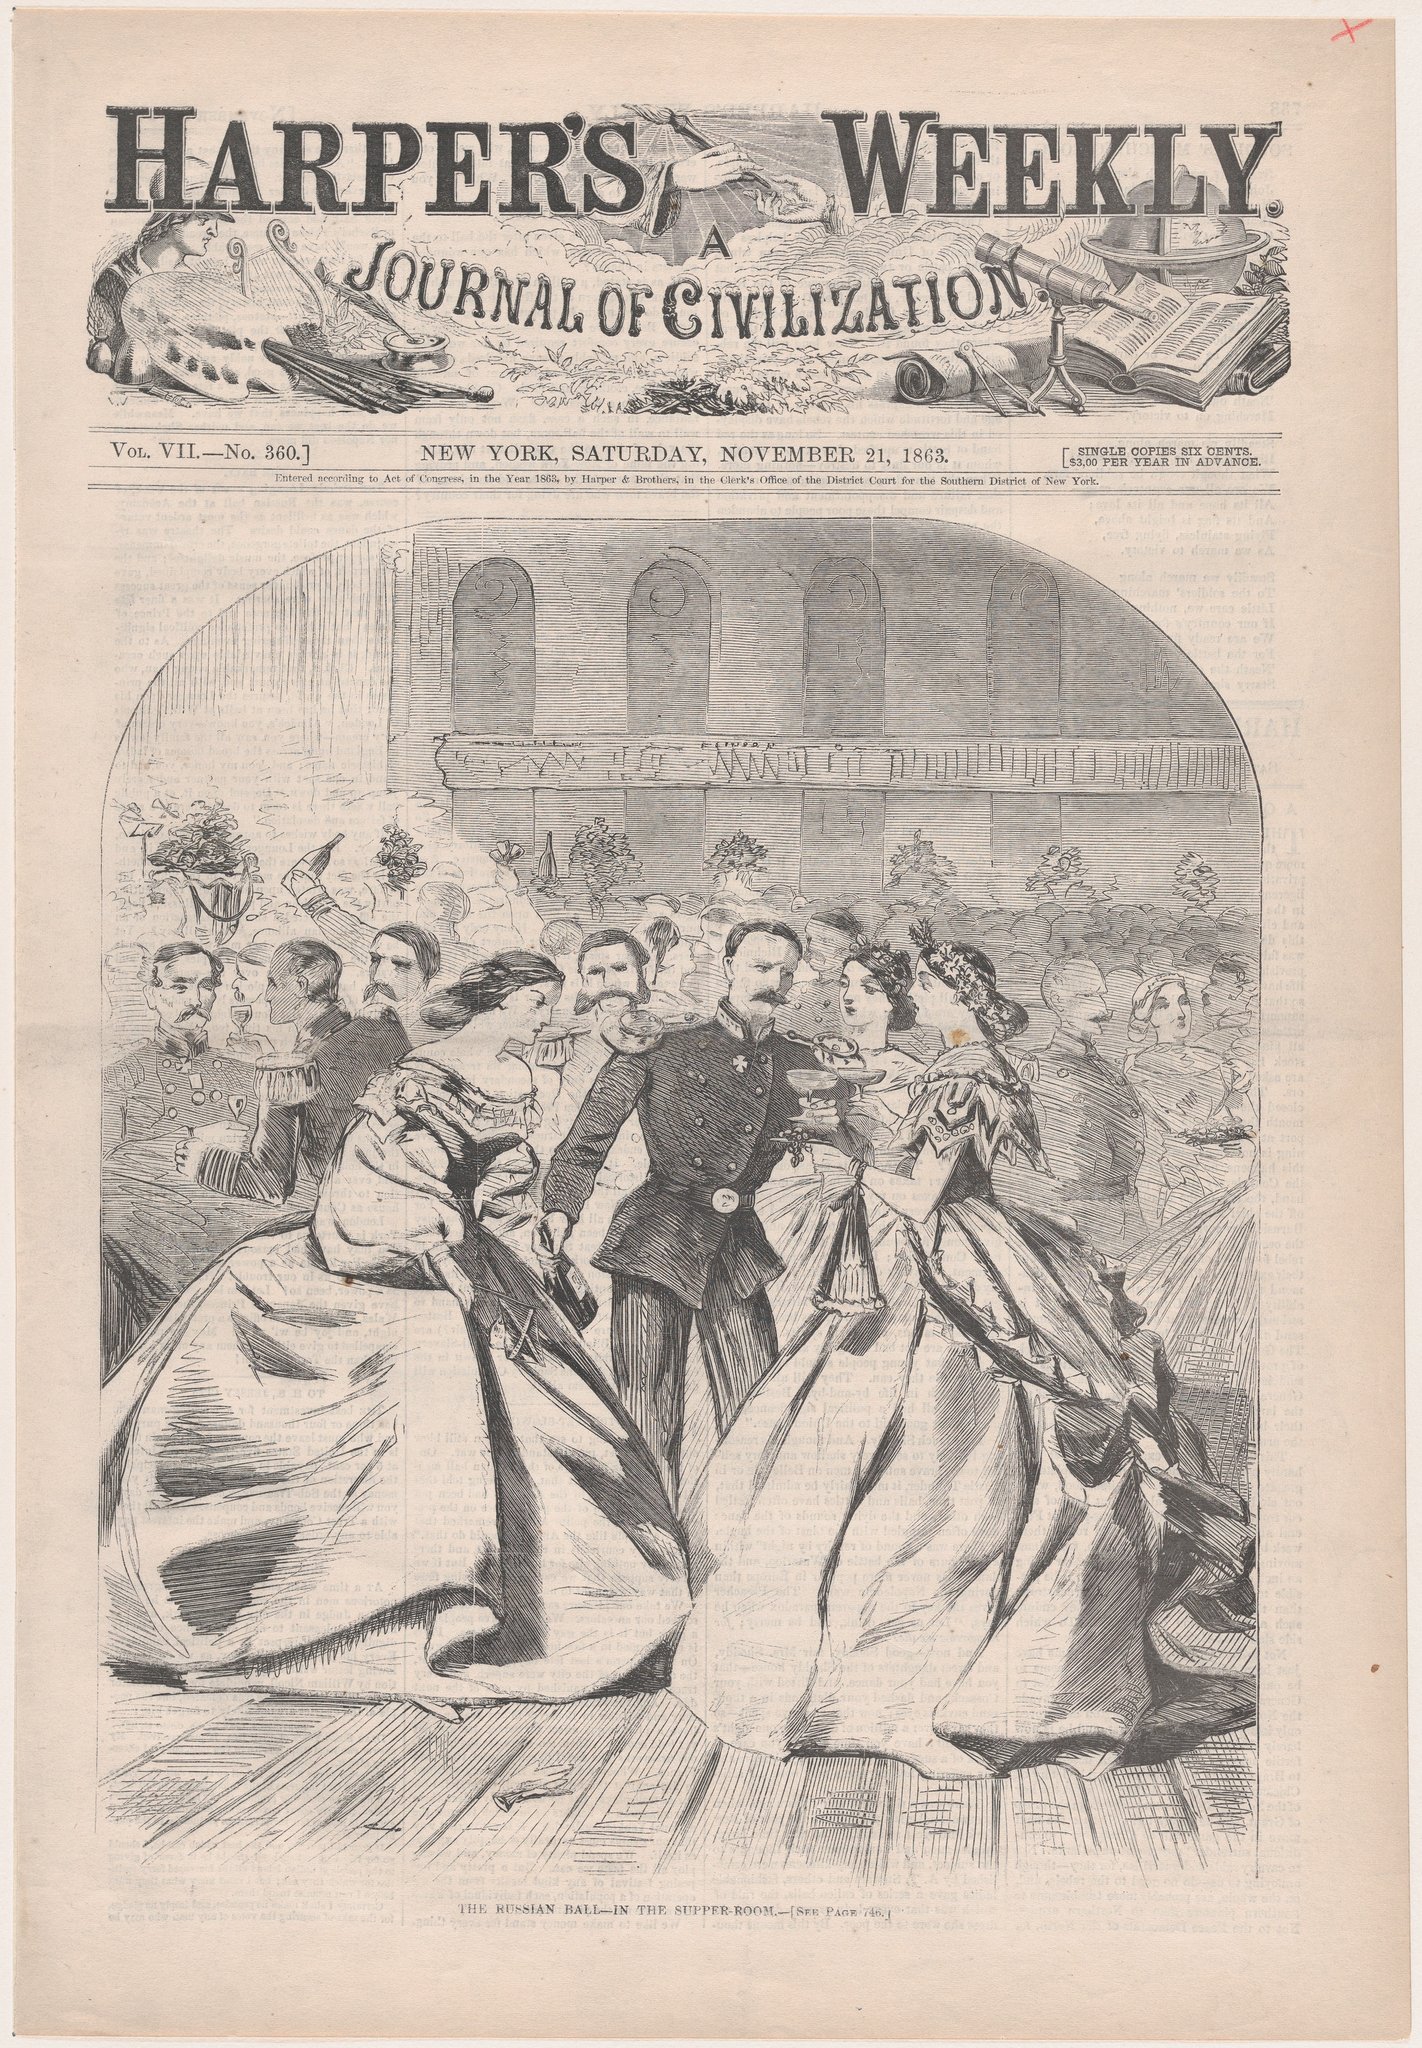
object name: print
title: The Russian Ball – In the Supper Room (from "Harper's Weekly," Vol. VII)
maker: winslow homer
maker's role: artist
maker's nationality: american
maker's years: 1836-1910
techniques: engraving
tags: men,women,drinking